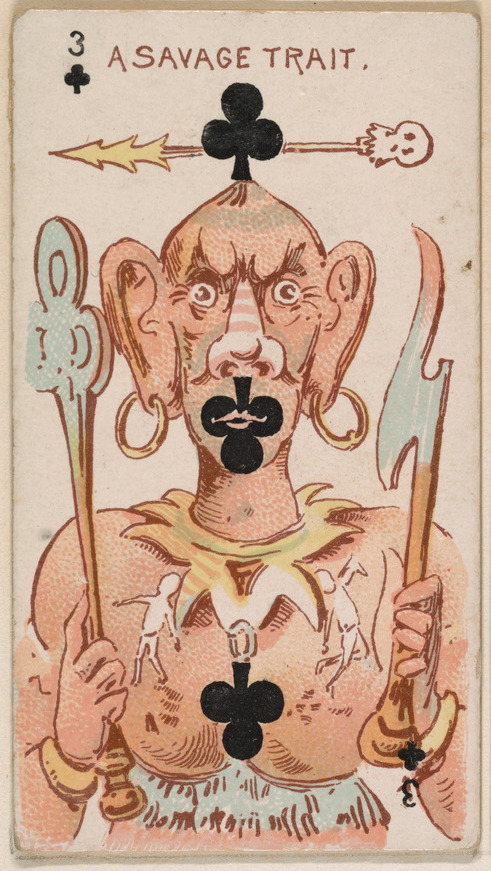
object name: print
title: Three of Clubs, A Savage Trait, from Harlequin Cards, 2nd Series (N220) issued by Kinney Bros.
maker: kinney brothers tobacco company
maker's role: publisher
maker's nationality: american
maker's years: 1869-2011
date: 1889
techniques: color lithograph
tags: playing cards